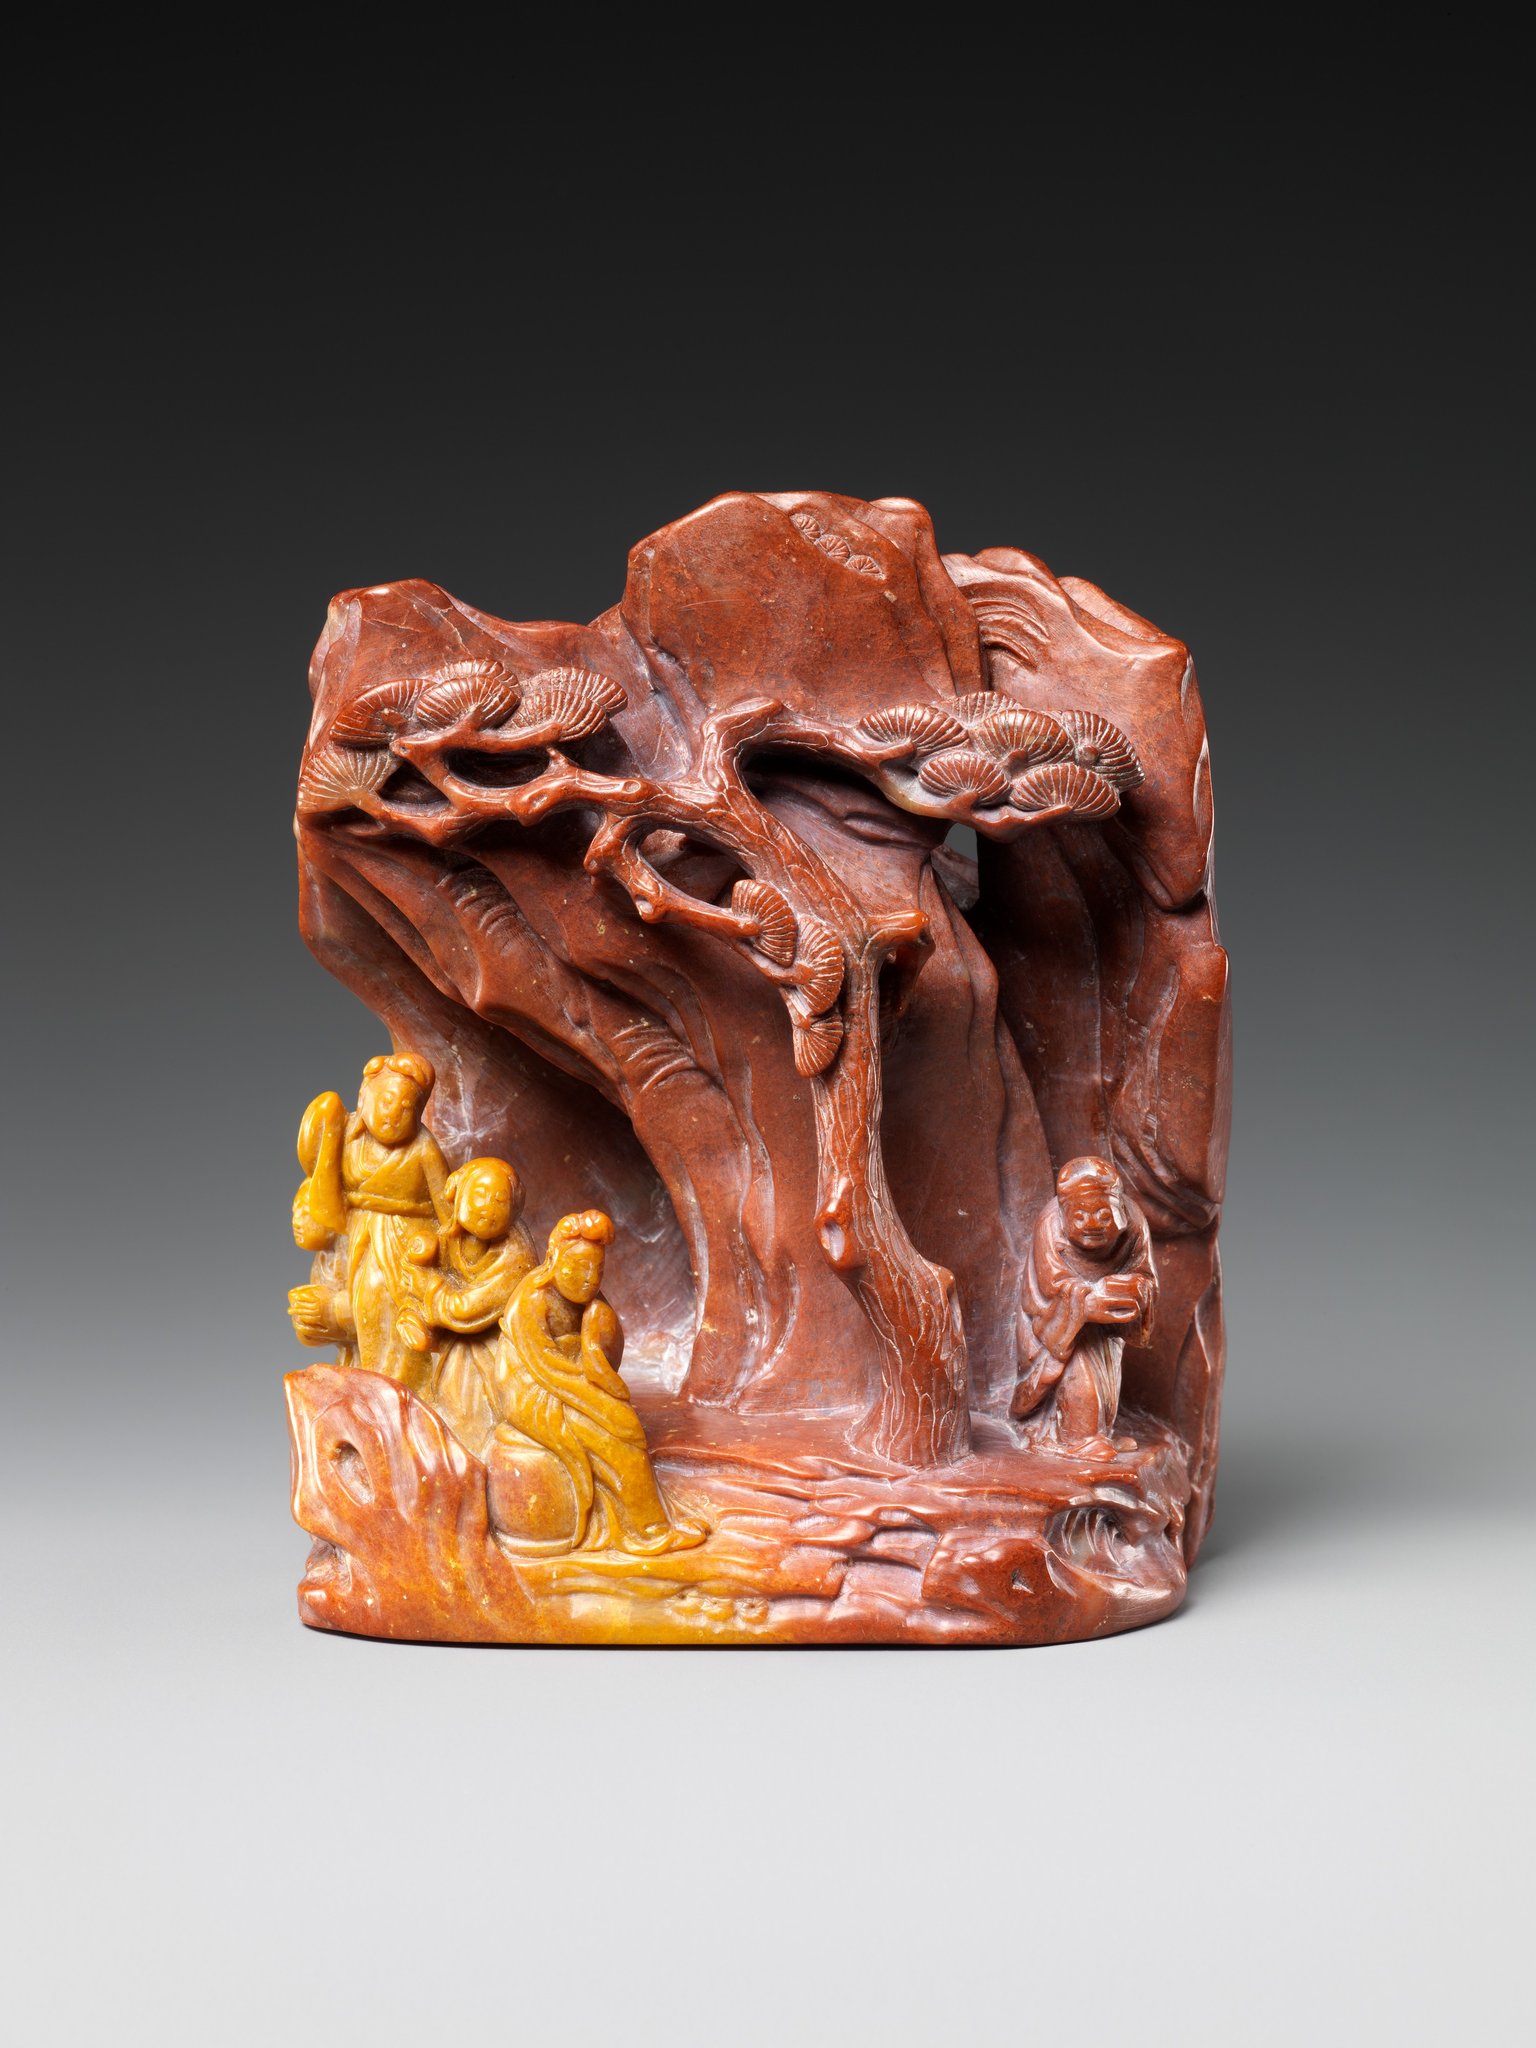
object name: relief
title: Ornament in the form of a mountain with figures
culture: chinese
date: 1767-1833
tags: women,mountains,trees